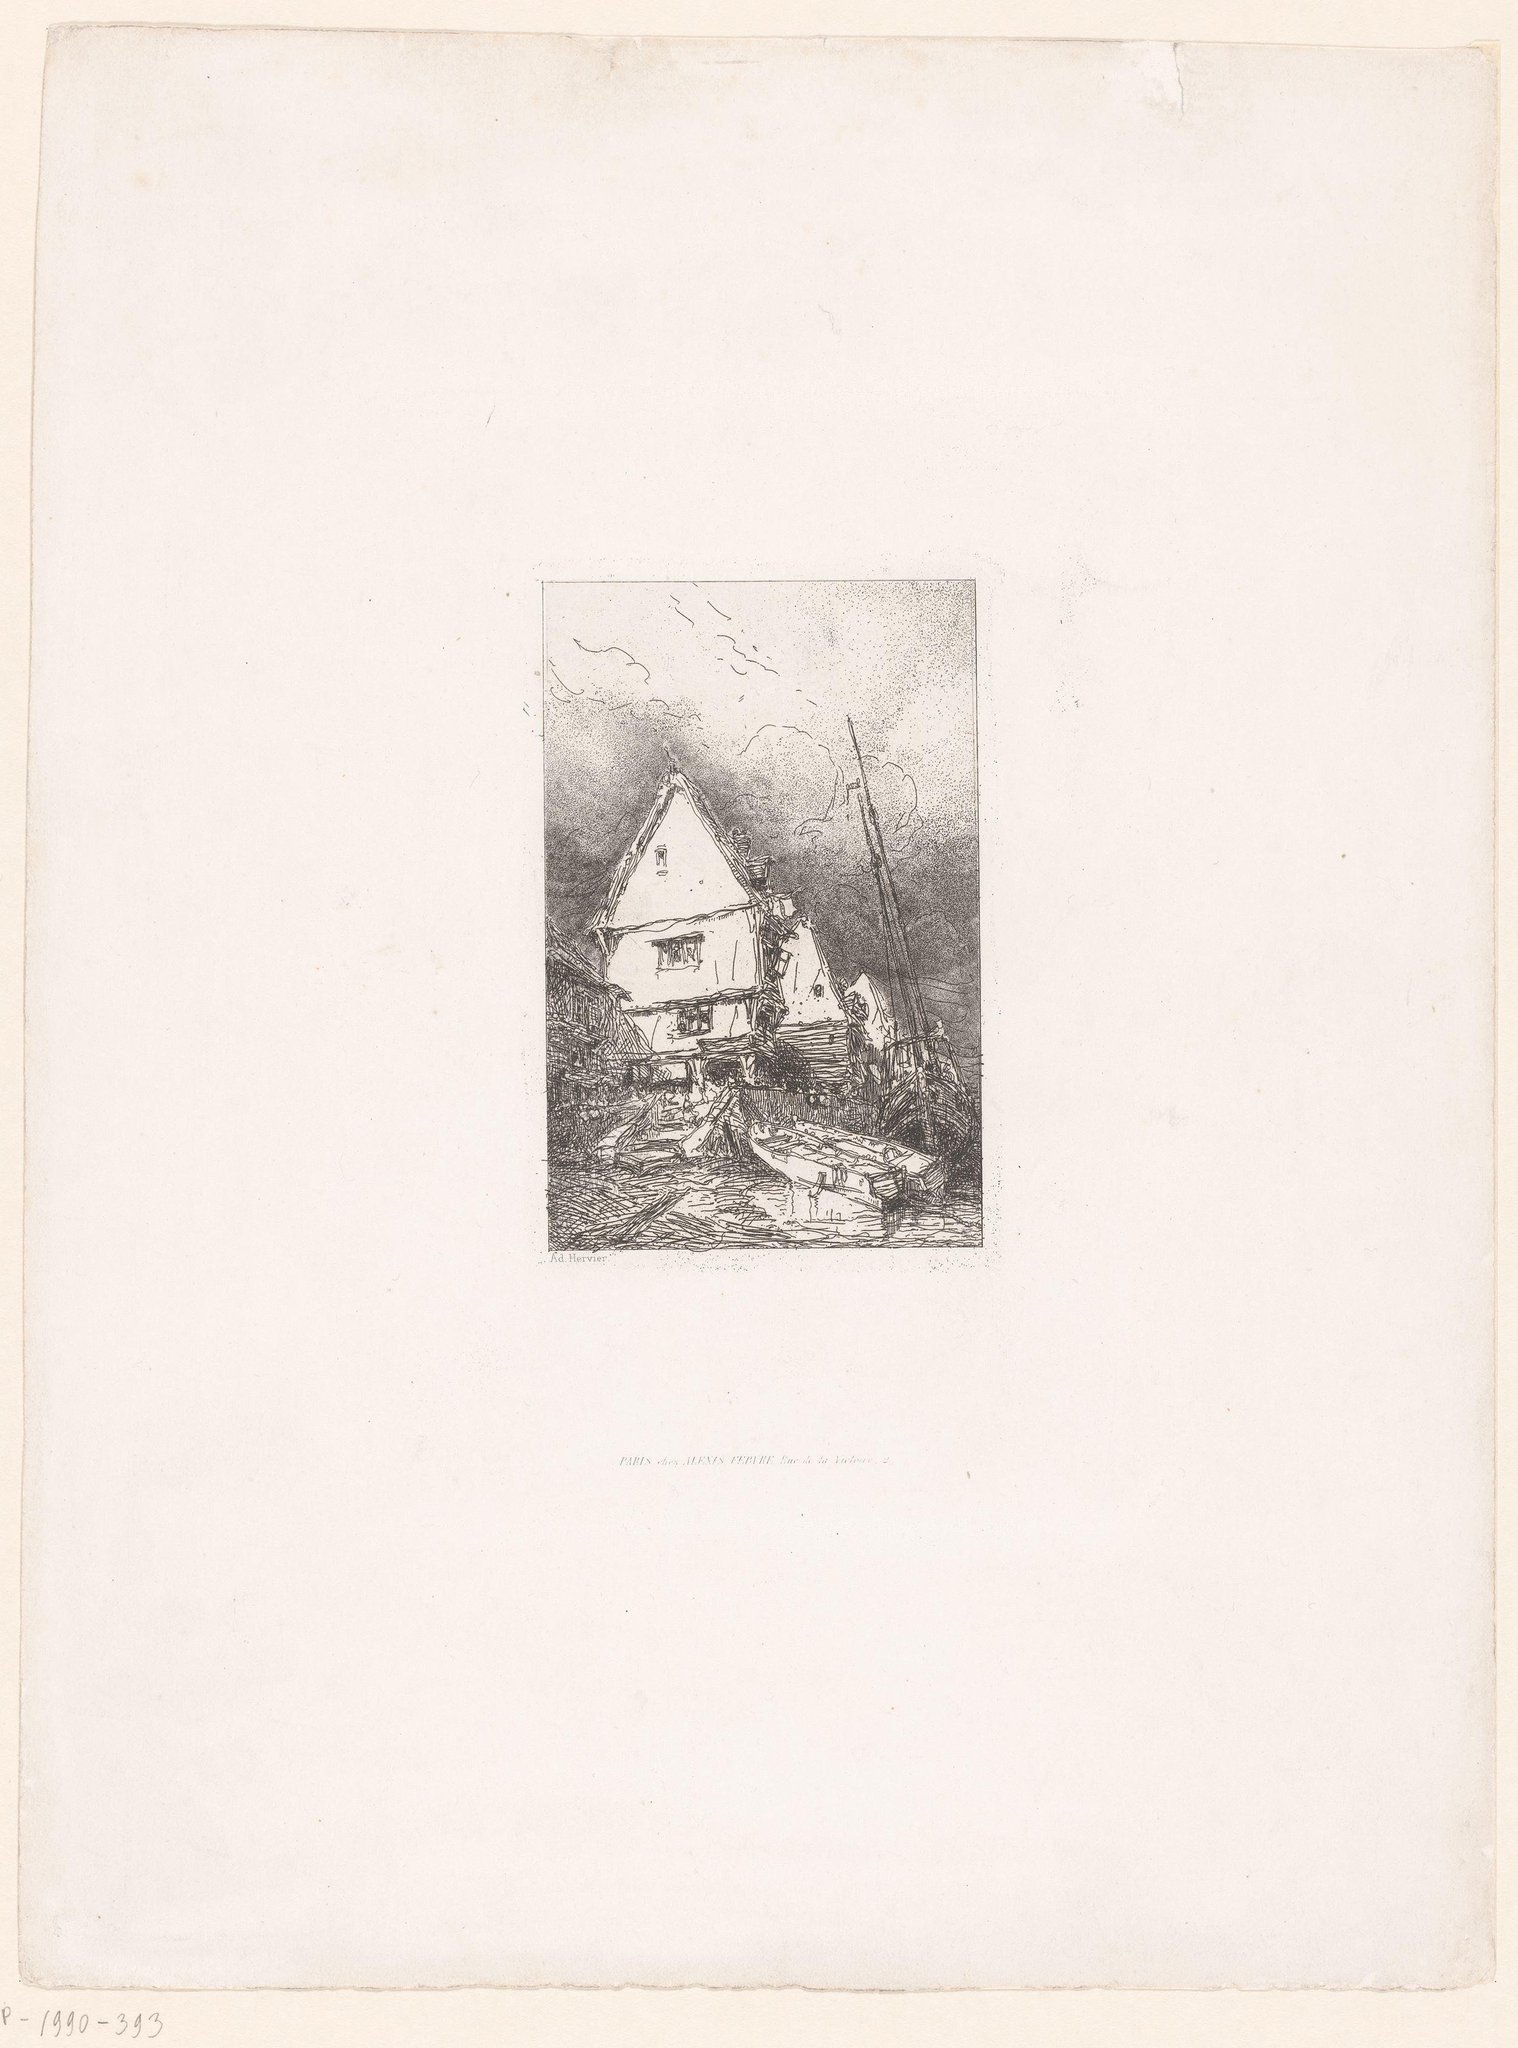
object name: print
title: Verschillende landschappen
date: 1843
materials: paper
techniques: aquatint, etching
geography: paris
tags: sailing-ship, sailing-boat, coast, boat propelled by man or animal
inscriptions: collector's mark: Lugt 2228, collector's mark: Lugt 2760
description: Maakt deel uit van een achtdelige serie met landschappen uit 1843.